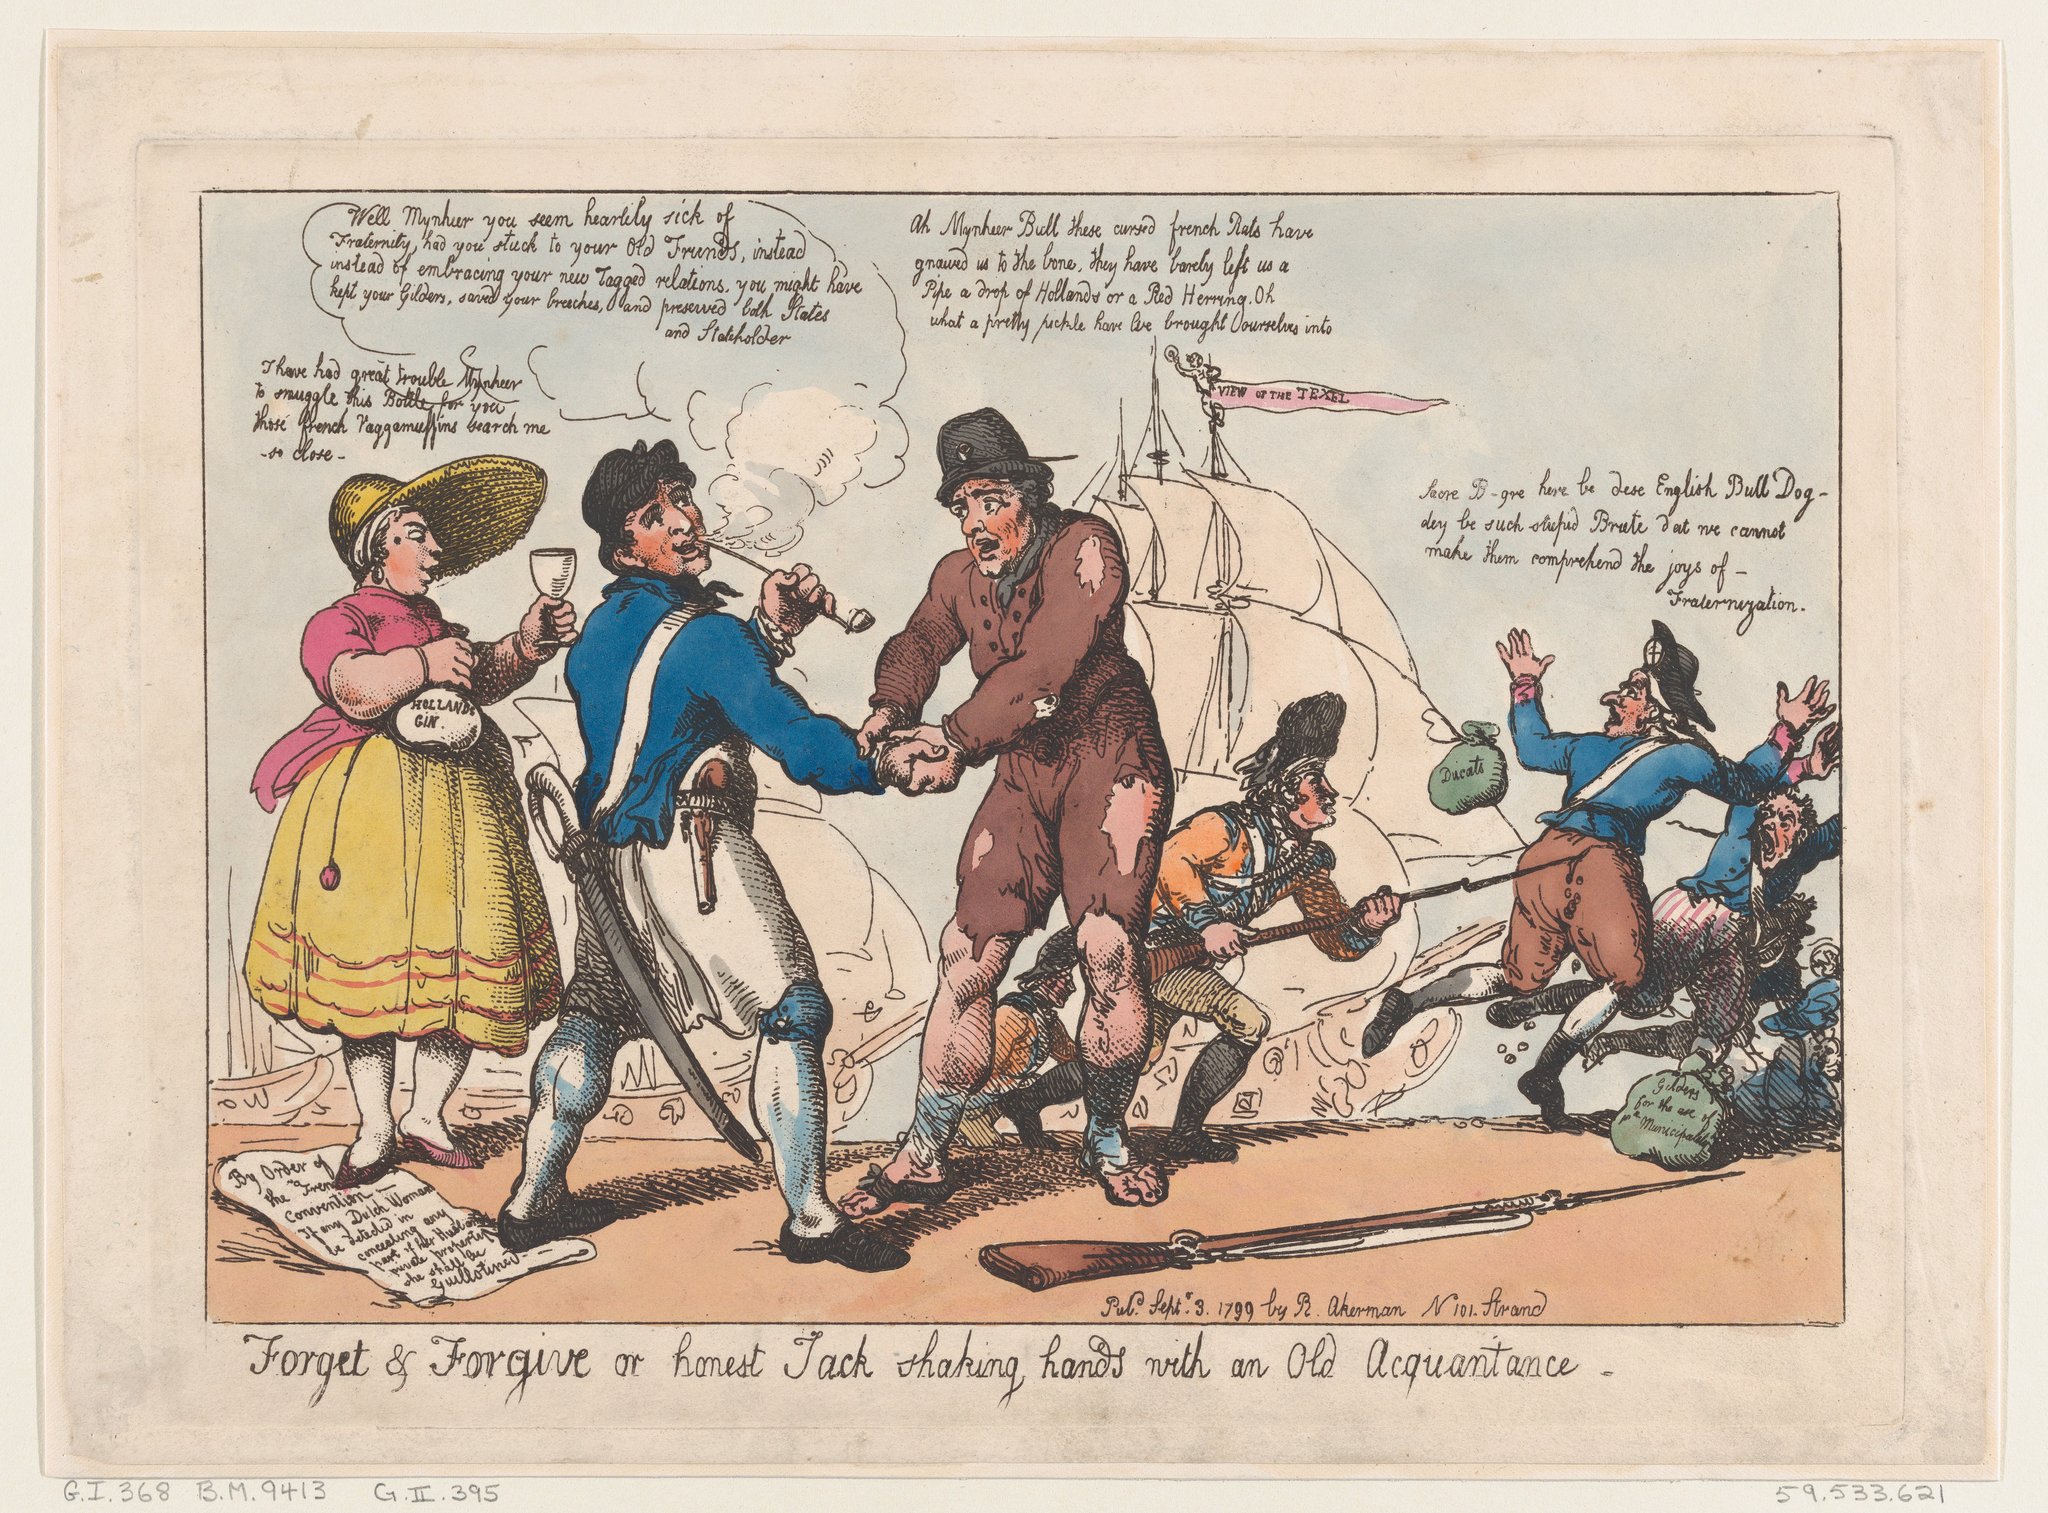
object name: print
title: Forget & Forgive, or Honest Jack Shaking Hands with and Old Acquaintance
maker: thomas rowlandson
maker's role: artist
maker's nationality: british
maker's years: 1757-1827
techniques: etching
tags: satire,firearms,men,women